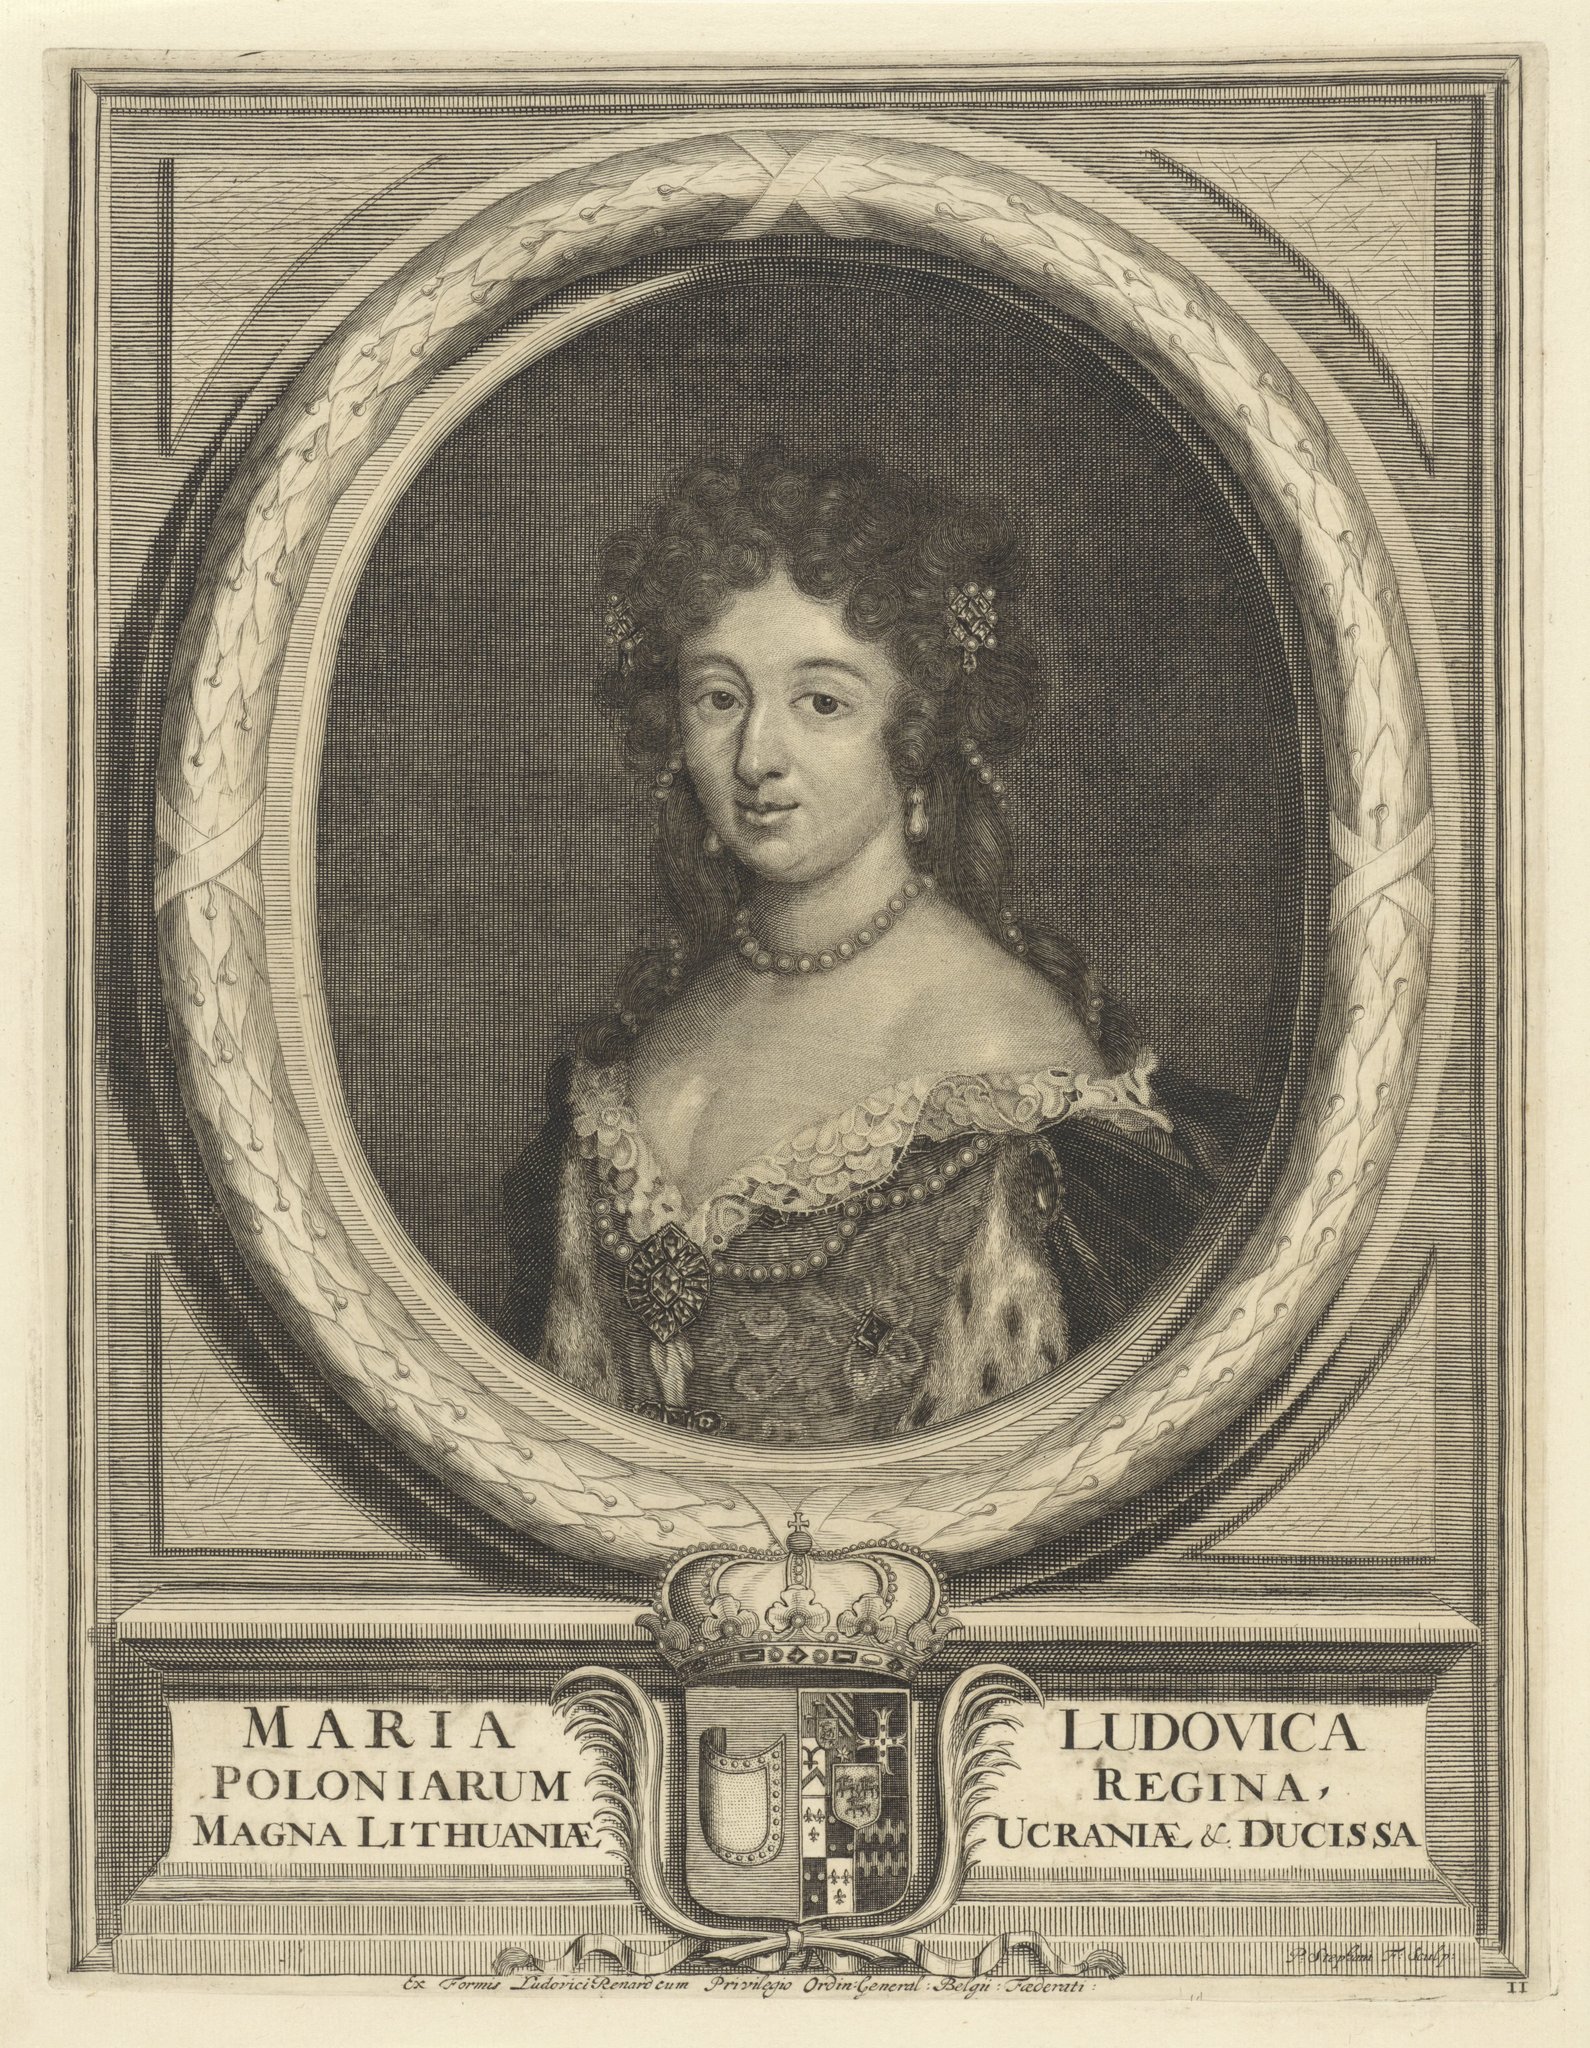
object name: print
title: Portret van Maria Casimira Ludovica, koningin van Polen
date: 1708-1711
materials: paper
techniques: engraving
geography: amsterdam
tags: queen, empress, etc. (wife of a ruler)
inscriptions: collector's mark: Lugt 2228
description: Portret van Maria Casimira Ludovica, koningin van Polen, met een parelsnoer om haar hals en sieraden in het haar. Midden onder haar gekroonde wapenschild. Rechtsonder gemerkt: II.